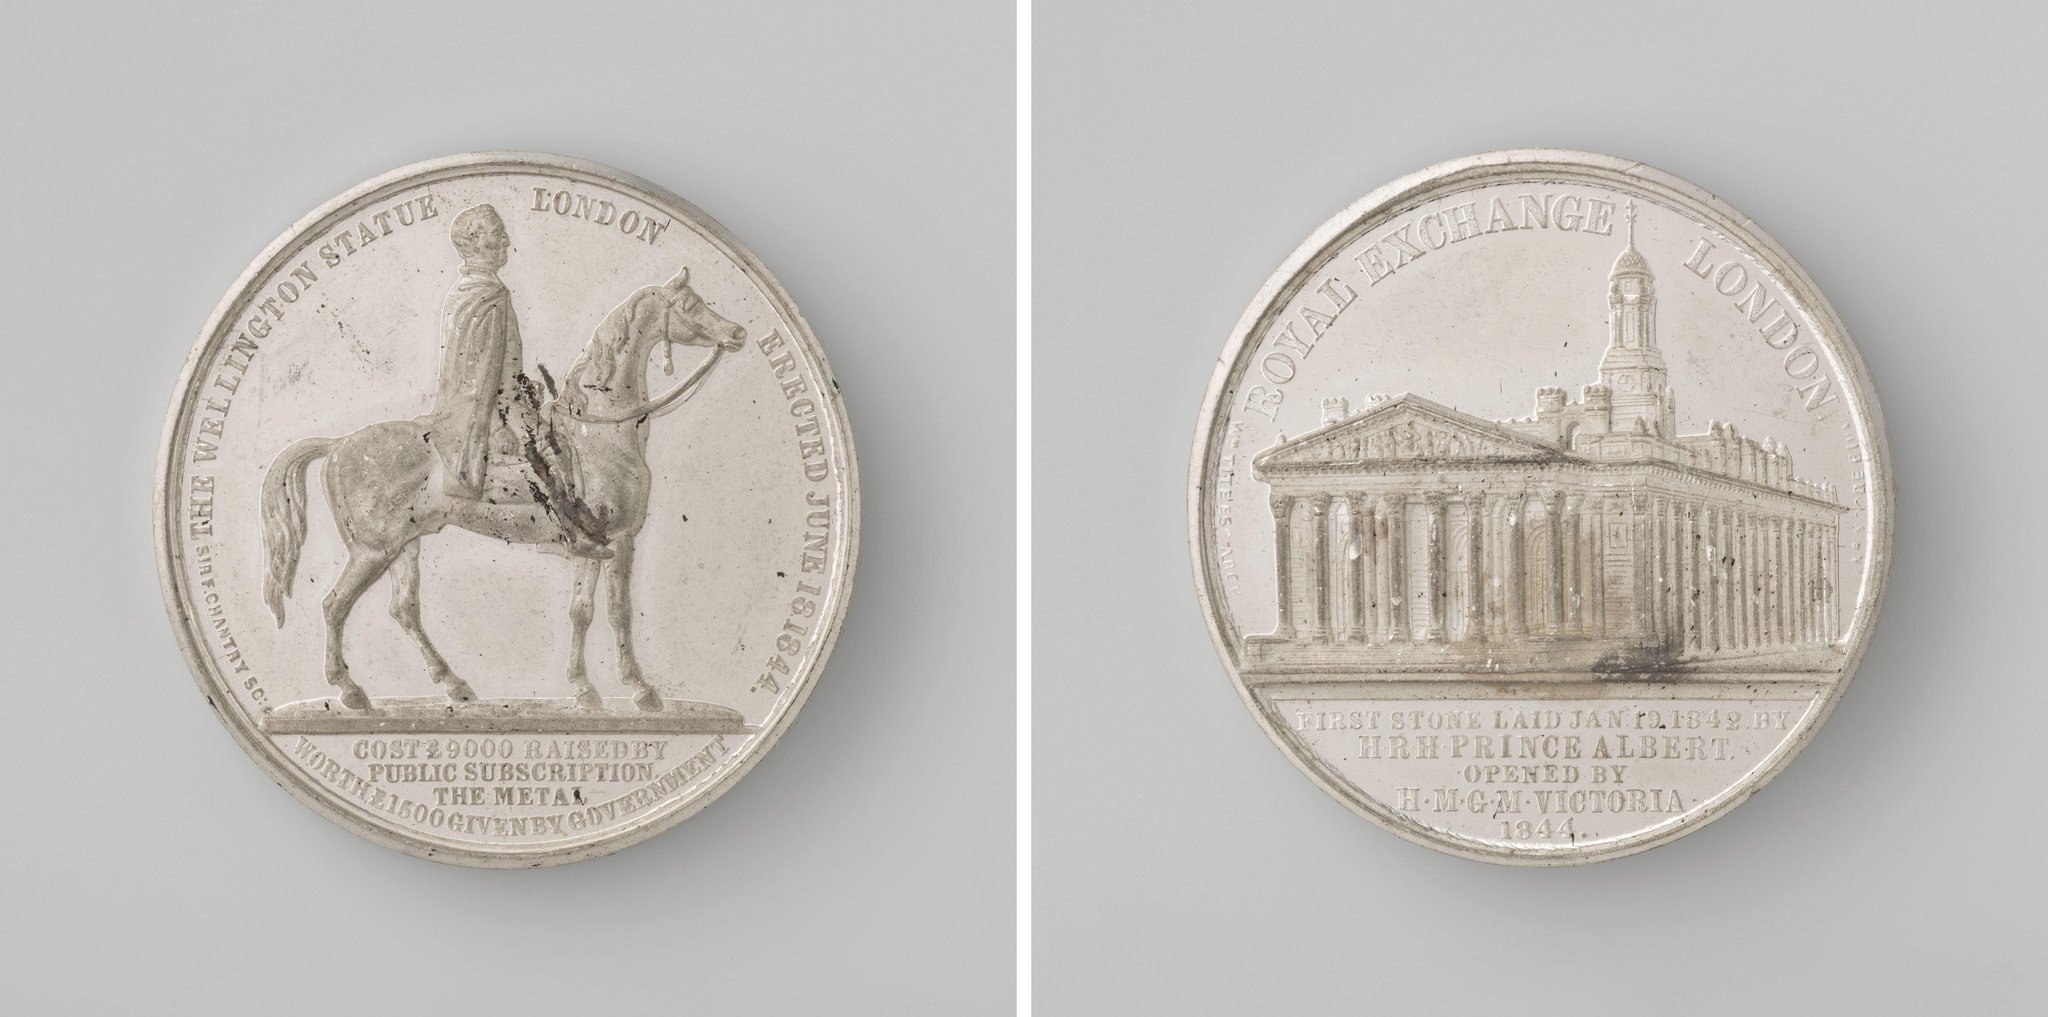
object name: history medal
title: Opening van de Beurs én onthulling van het ruiterstandbeeld van Wellington te Londen 1844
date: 1844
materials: tin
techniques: striking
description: Tinnen penning, op de voorzijde het ruiterstandbeeld naar rechts met omschrift en afsnedetekst, op de keerzijde het beursgebouw met omschrift en vijf regels afsnedetekst.